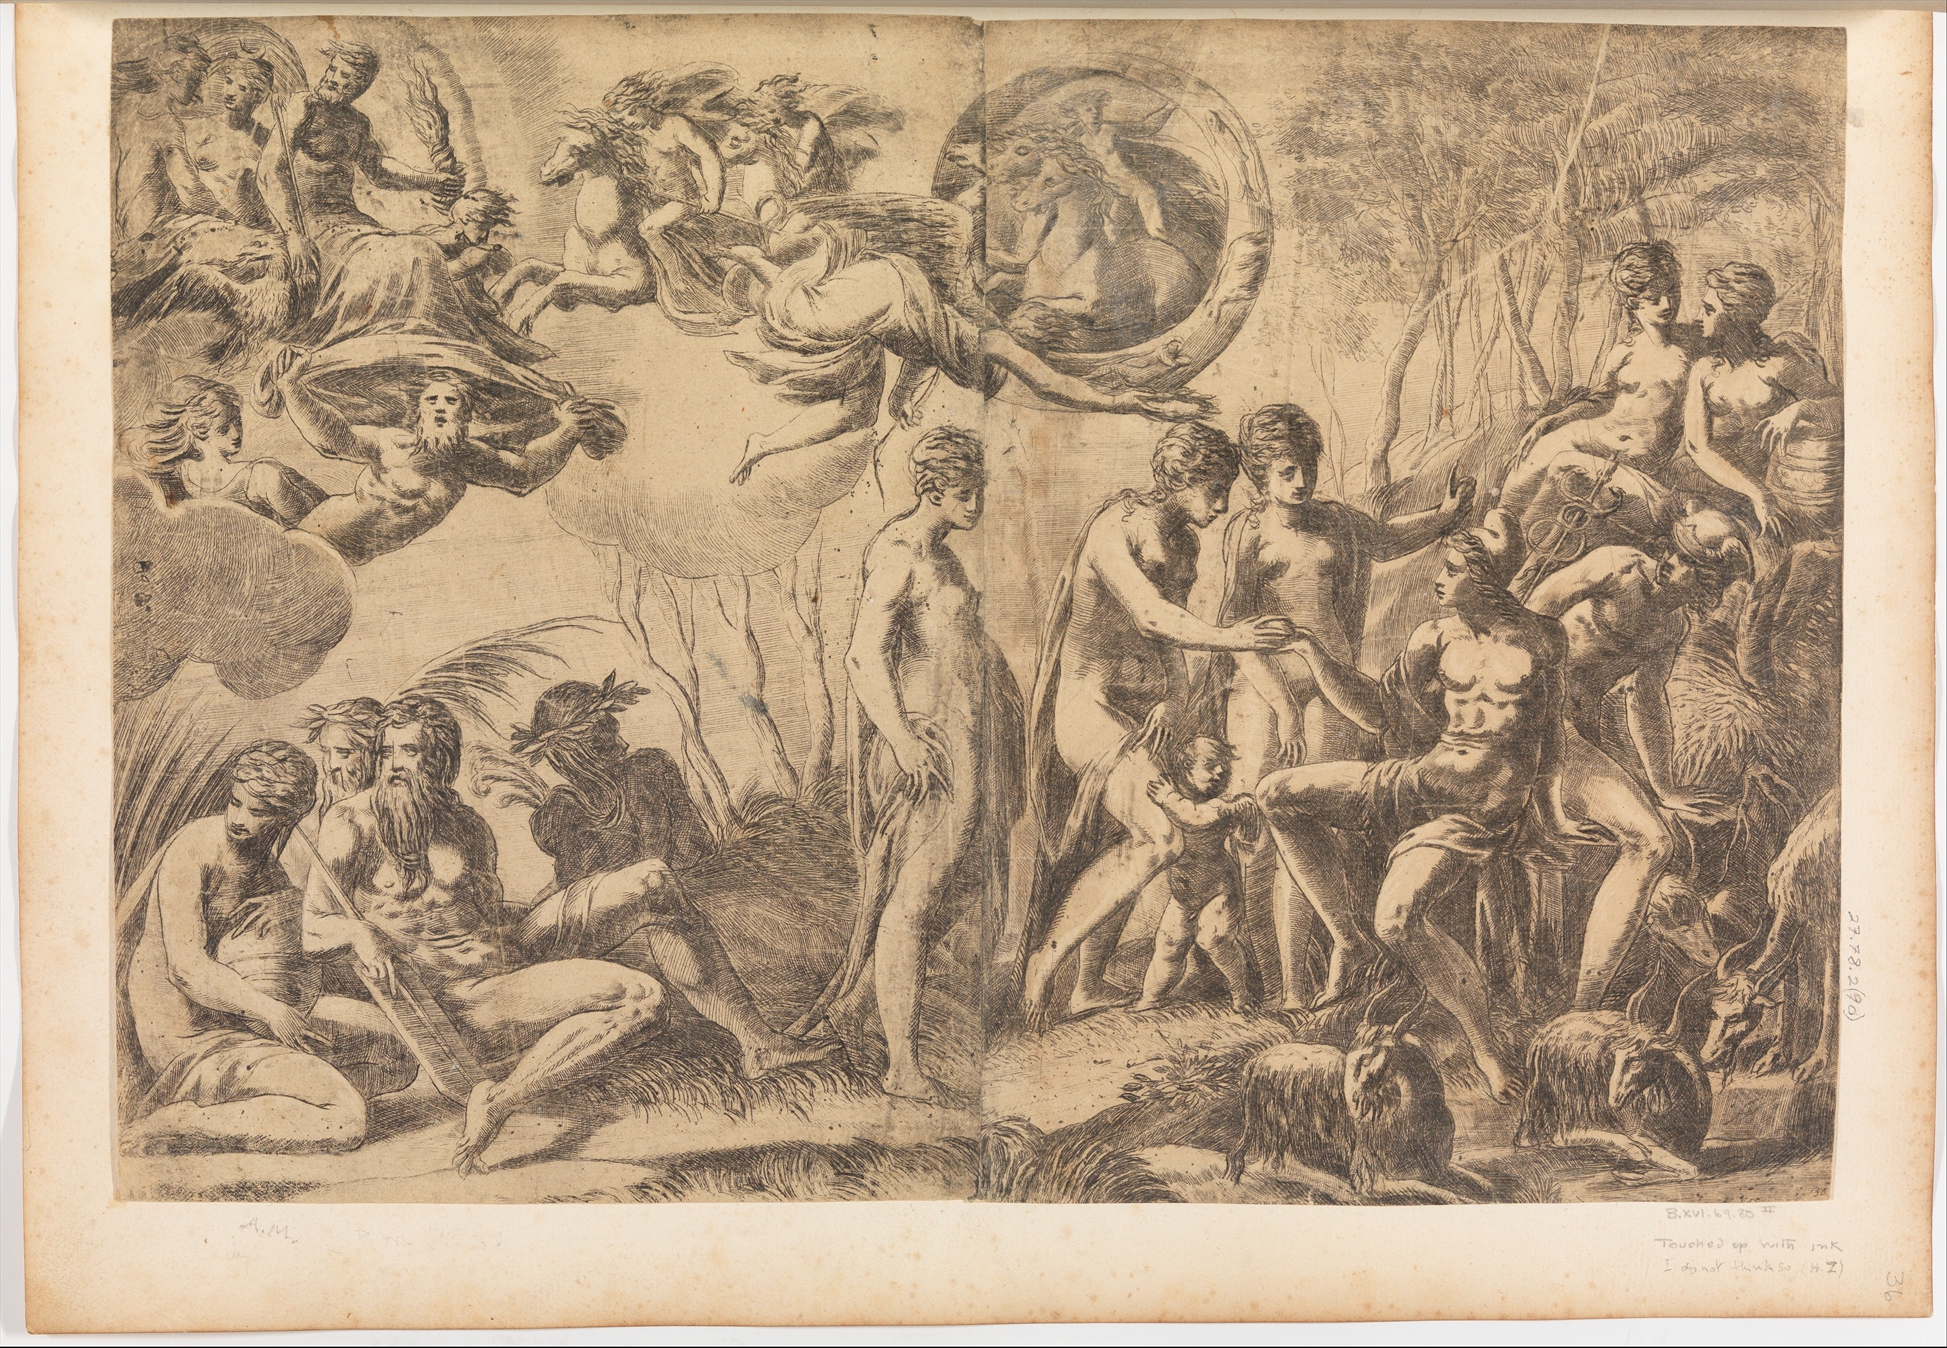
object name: print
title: The Judgment of Paris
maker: andrea schiavone (andrea meldola)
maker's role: artist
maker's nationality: italian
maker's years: 1510-1563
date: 1543-1546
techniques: etching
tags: male nudes,female nudes,pegasus